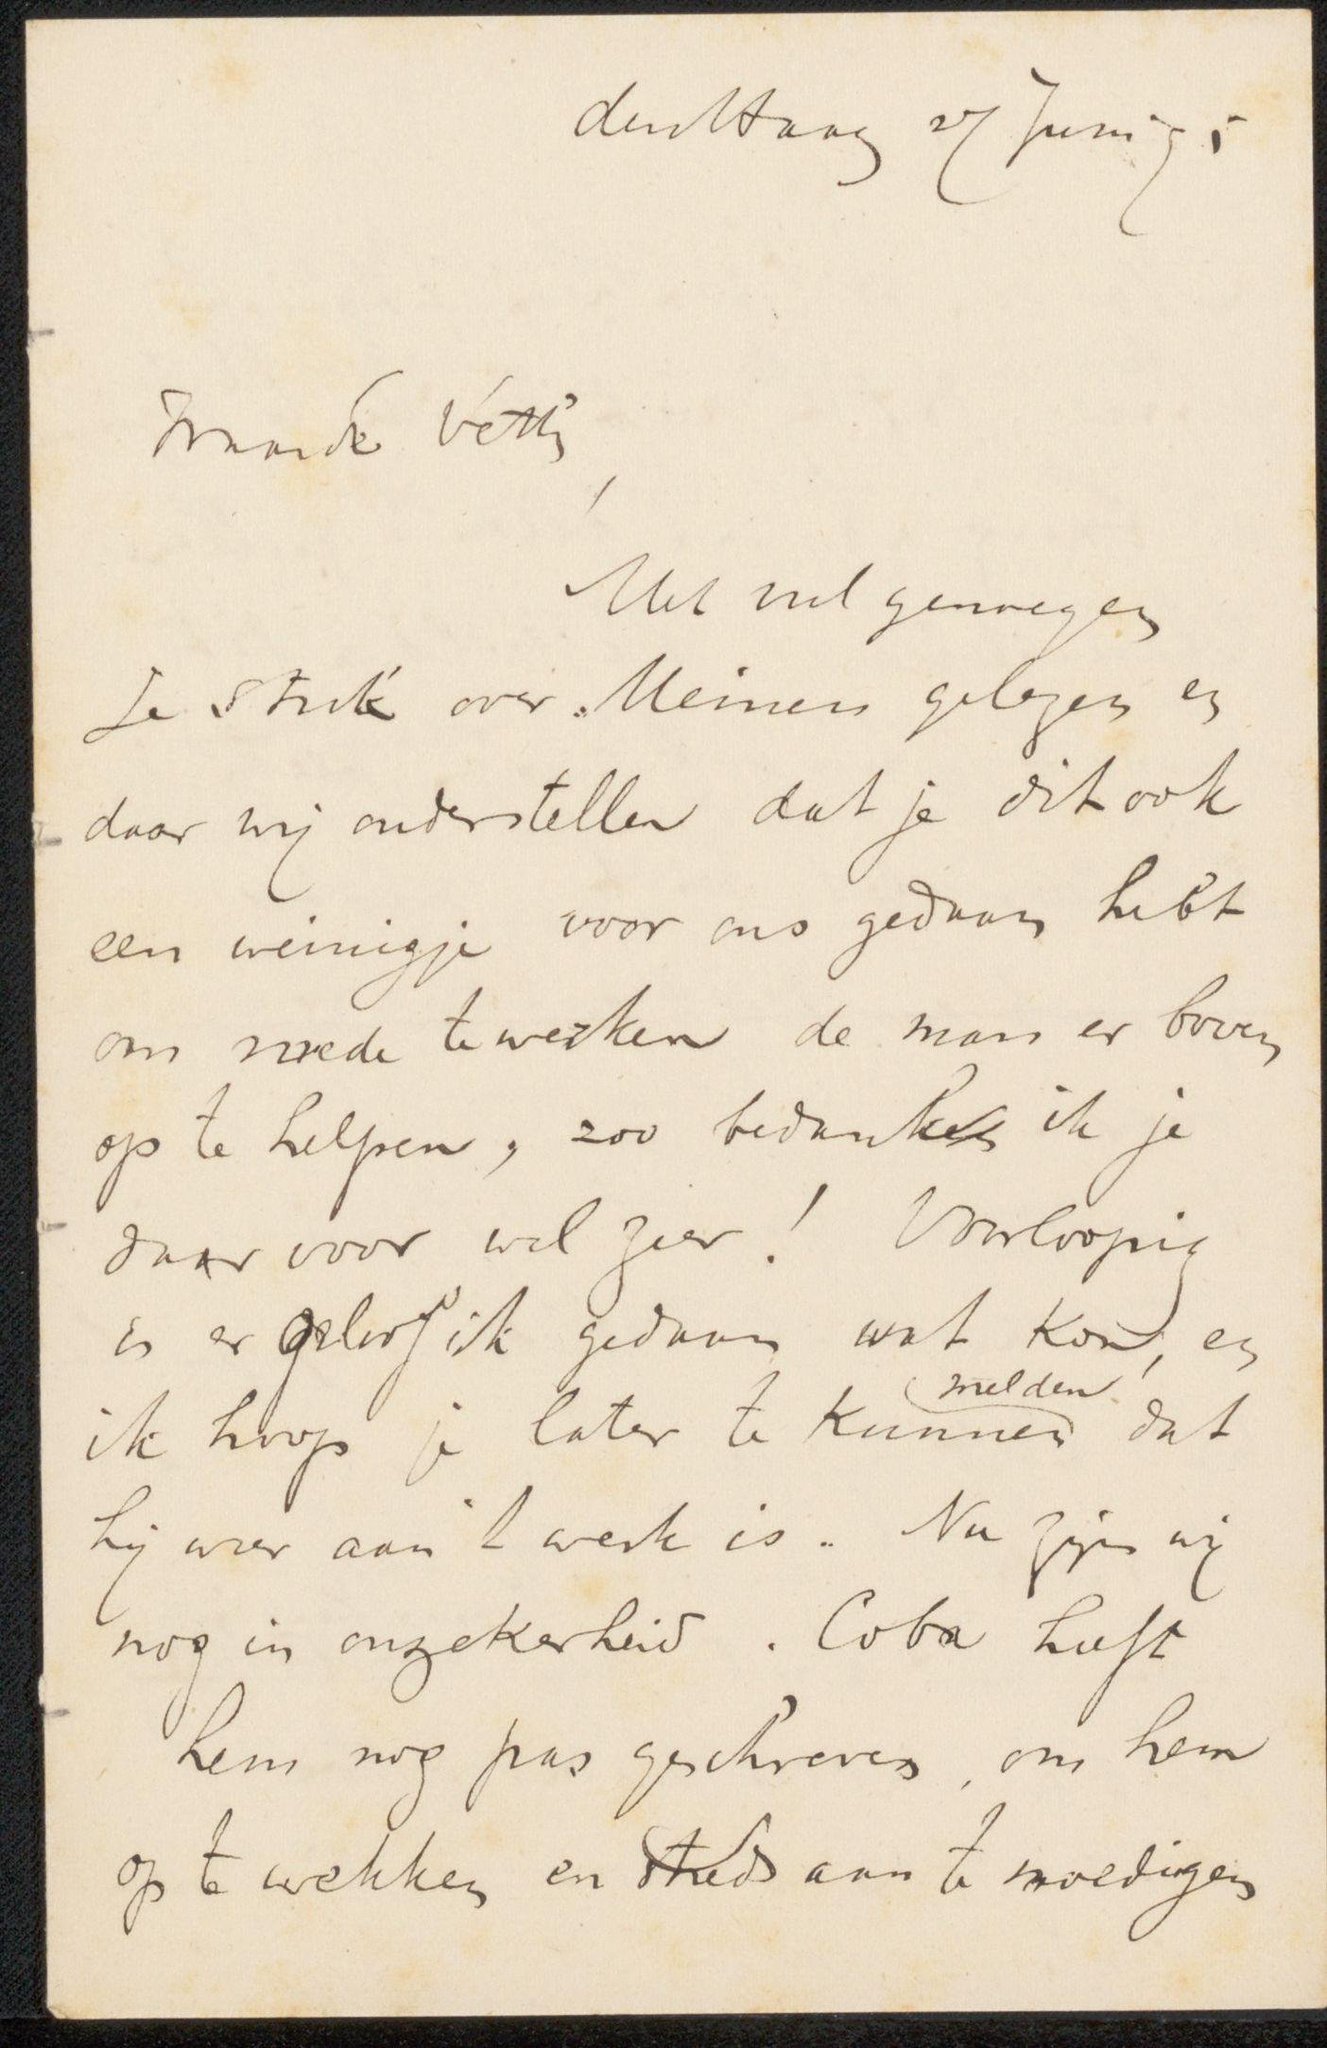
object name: letter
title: Brief aan Jan Veth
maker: willem bastiaan tholen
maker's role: draughtsman, painter, print maker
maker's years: 1860-1931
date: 1895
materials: ink, paper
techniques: pen, writing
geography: the hague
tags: designer, jan veth, auctioneer, j.j. biesing, isaac israels, painter, draughtsman, piet meiners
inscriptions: watermark, collector's mark: ‘RPK’